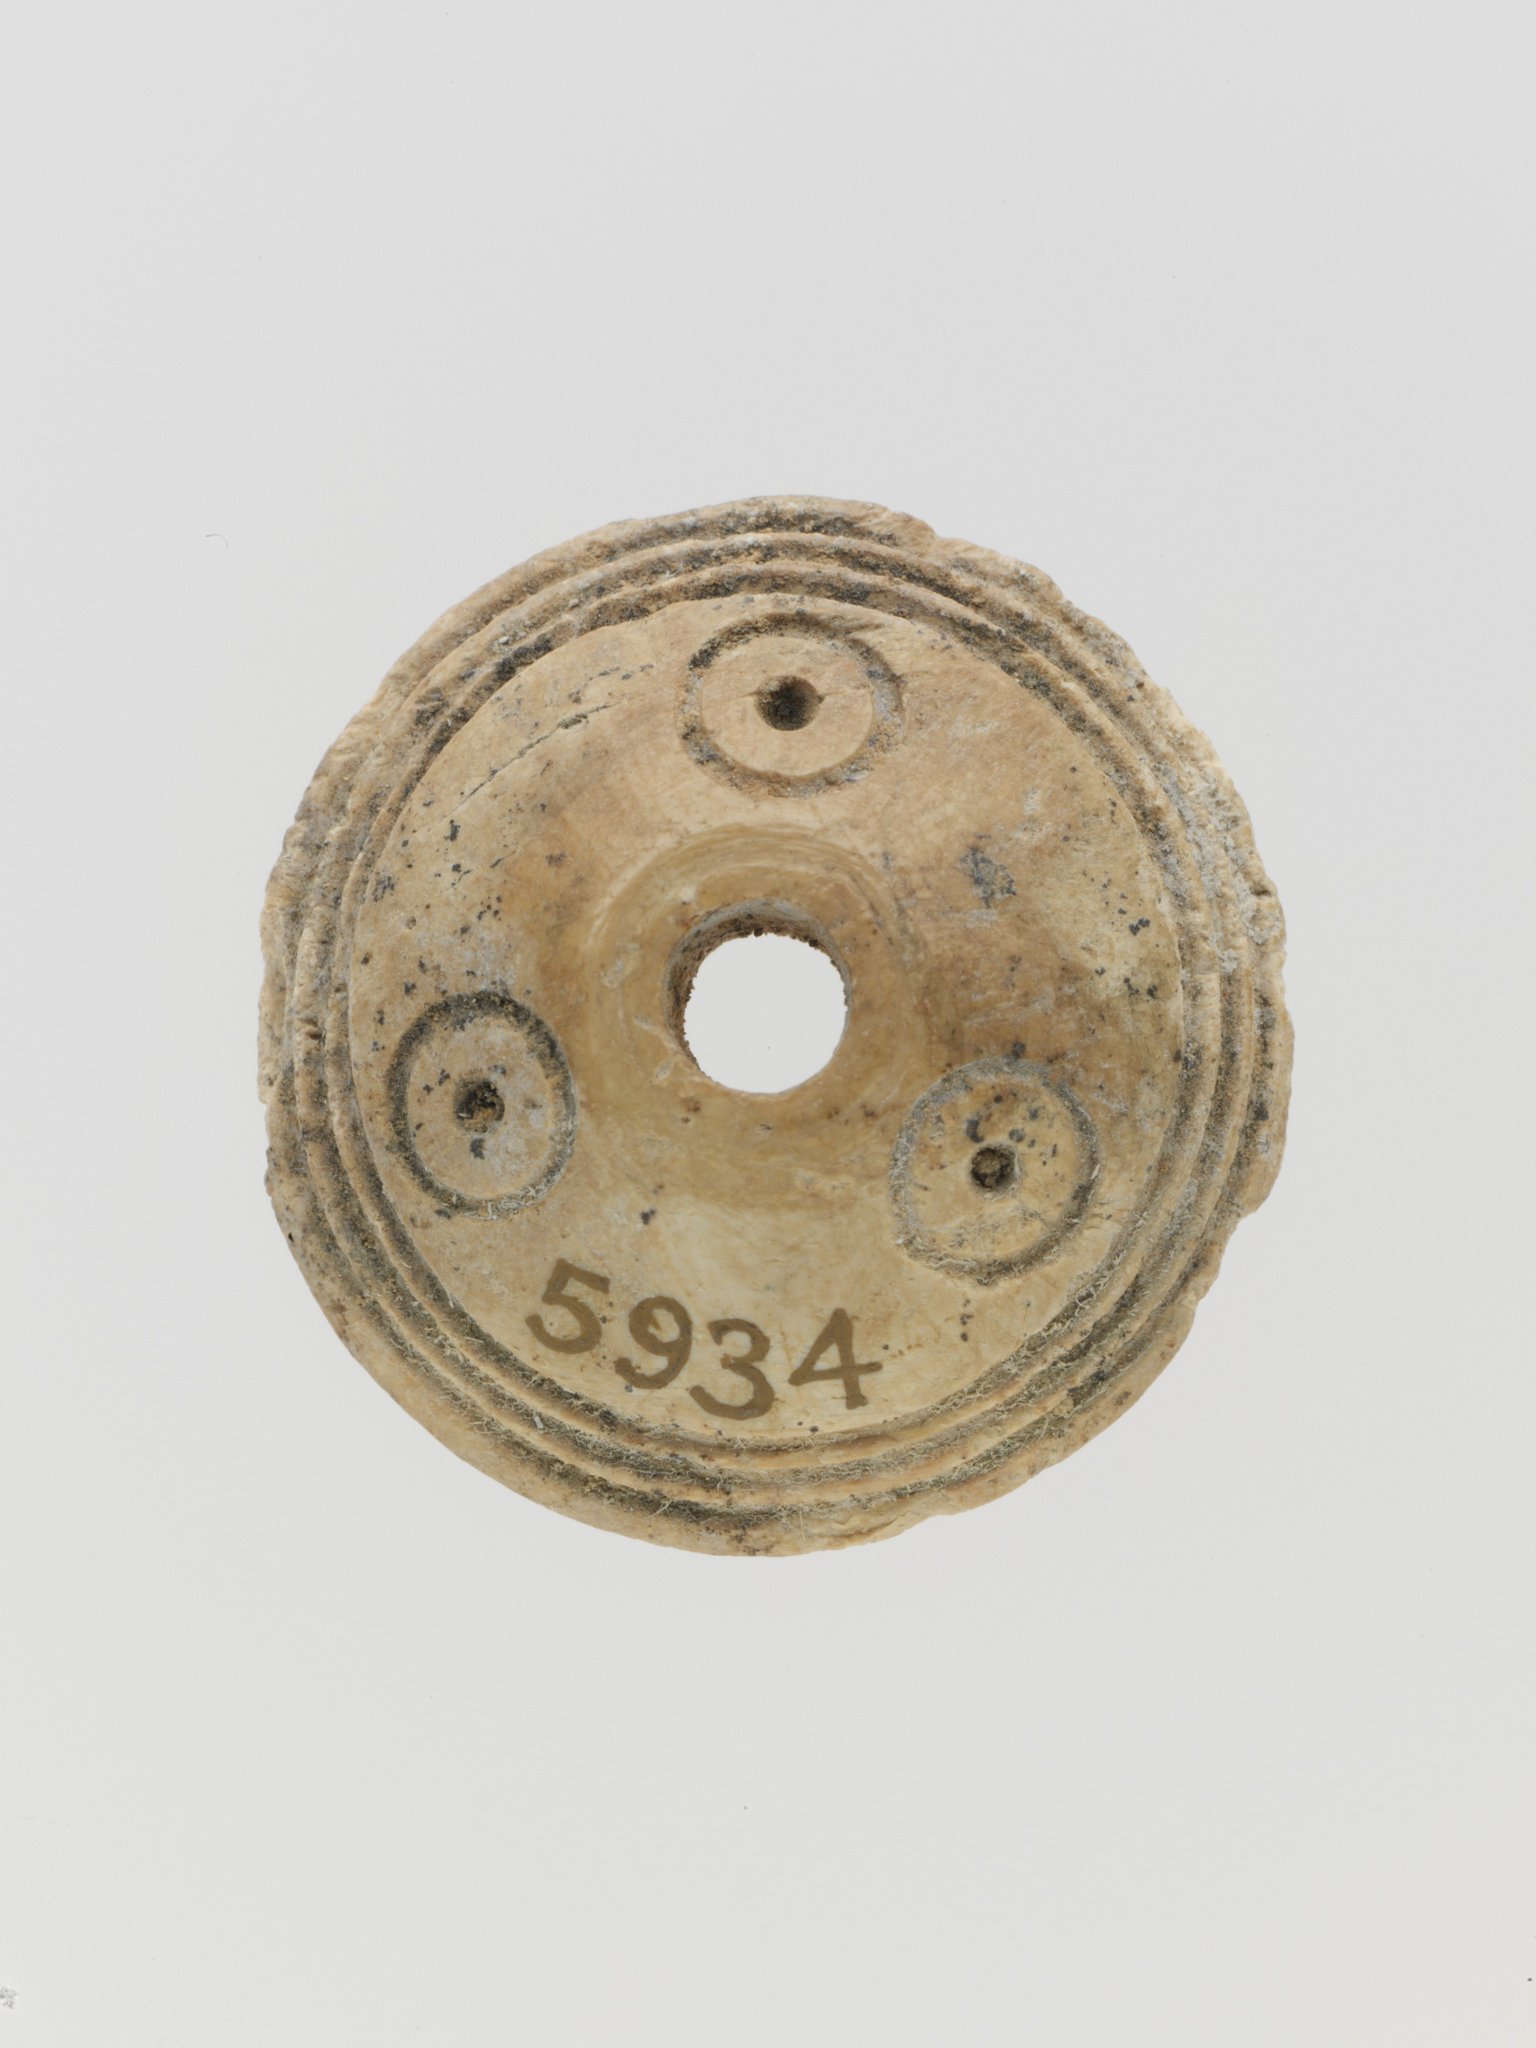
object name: spindle whorl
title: Bone spindle whorl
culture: cypriot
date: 1600-1050 BCE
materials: bone